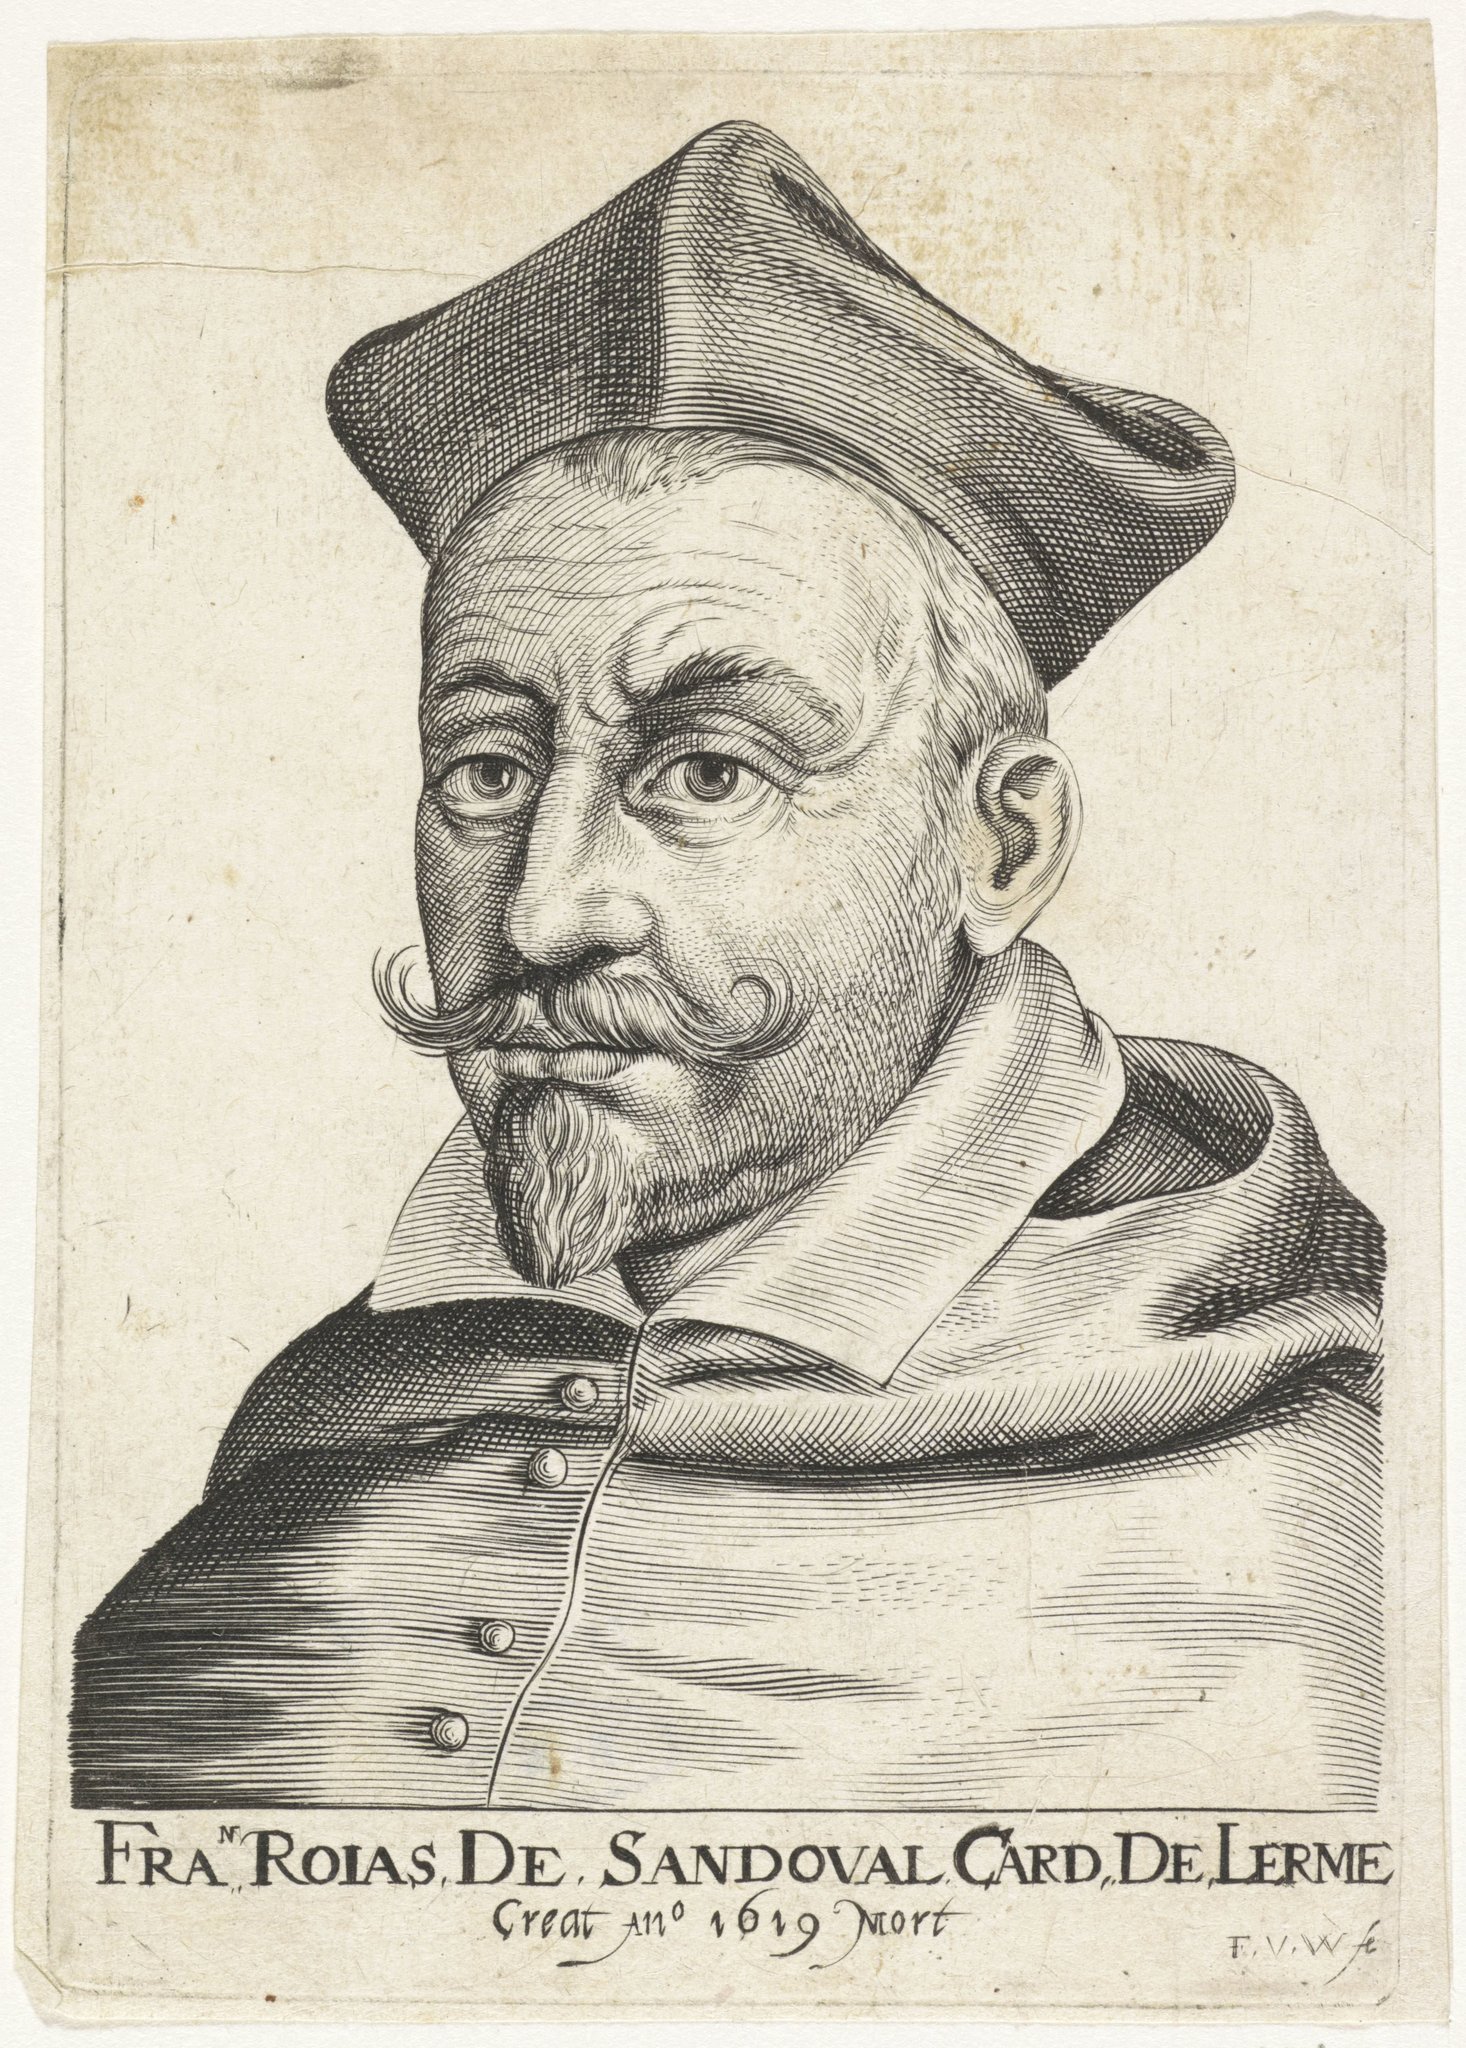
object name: print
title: Portretten van kardinalen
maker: frans van den wijngaerde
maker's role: print maker, publisher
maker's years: 1614-1679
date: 1636-1679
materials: paper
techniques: engraving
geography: antwerp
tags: cardinal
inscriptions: collector's mark: Lugt 2228